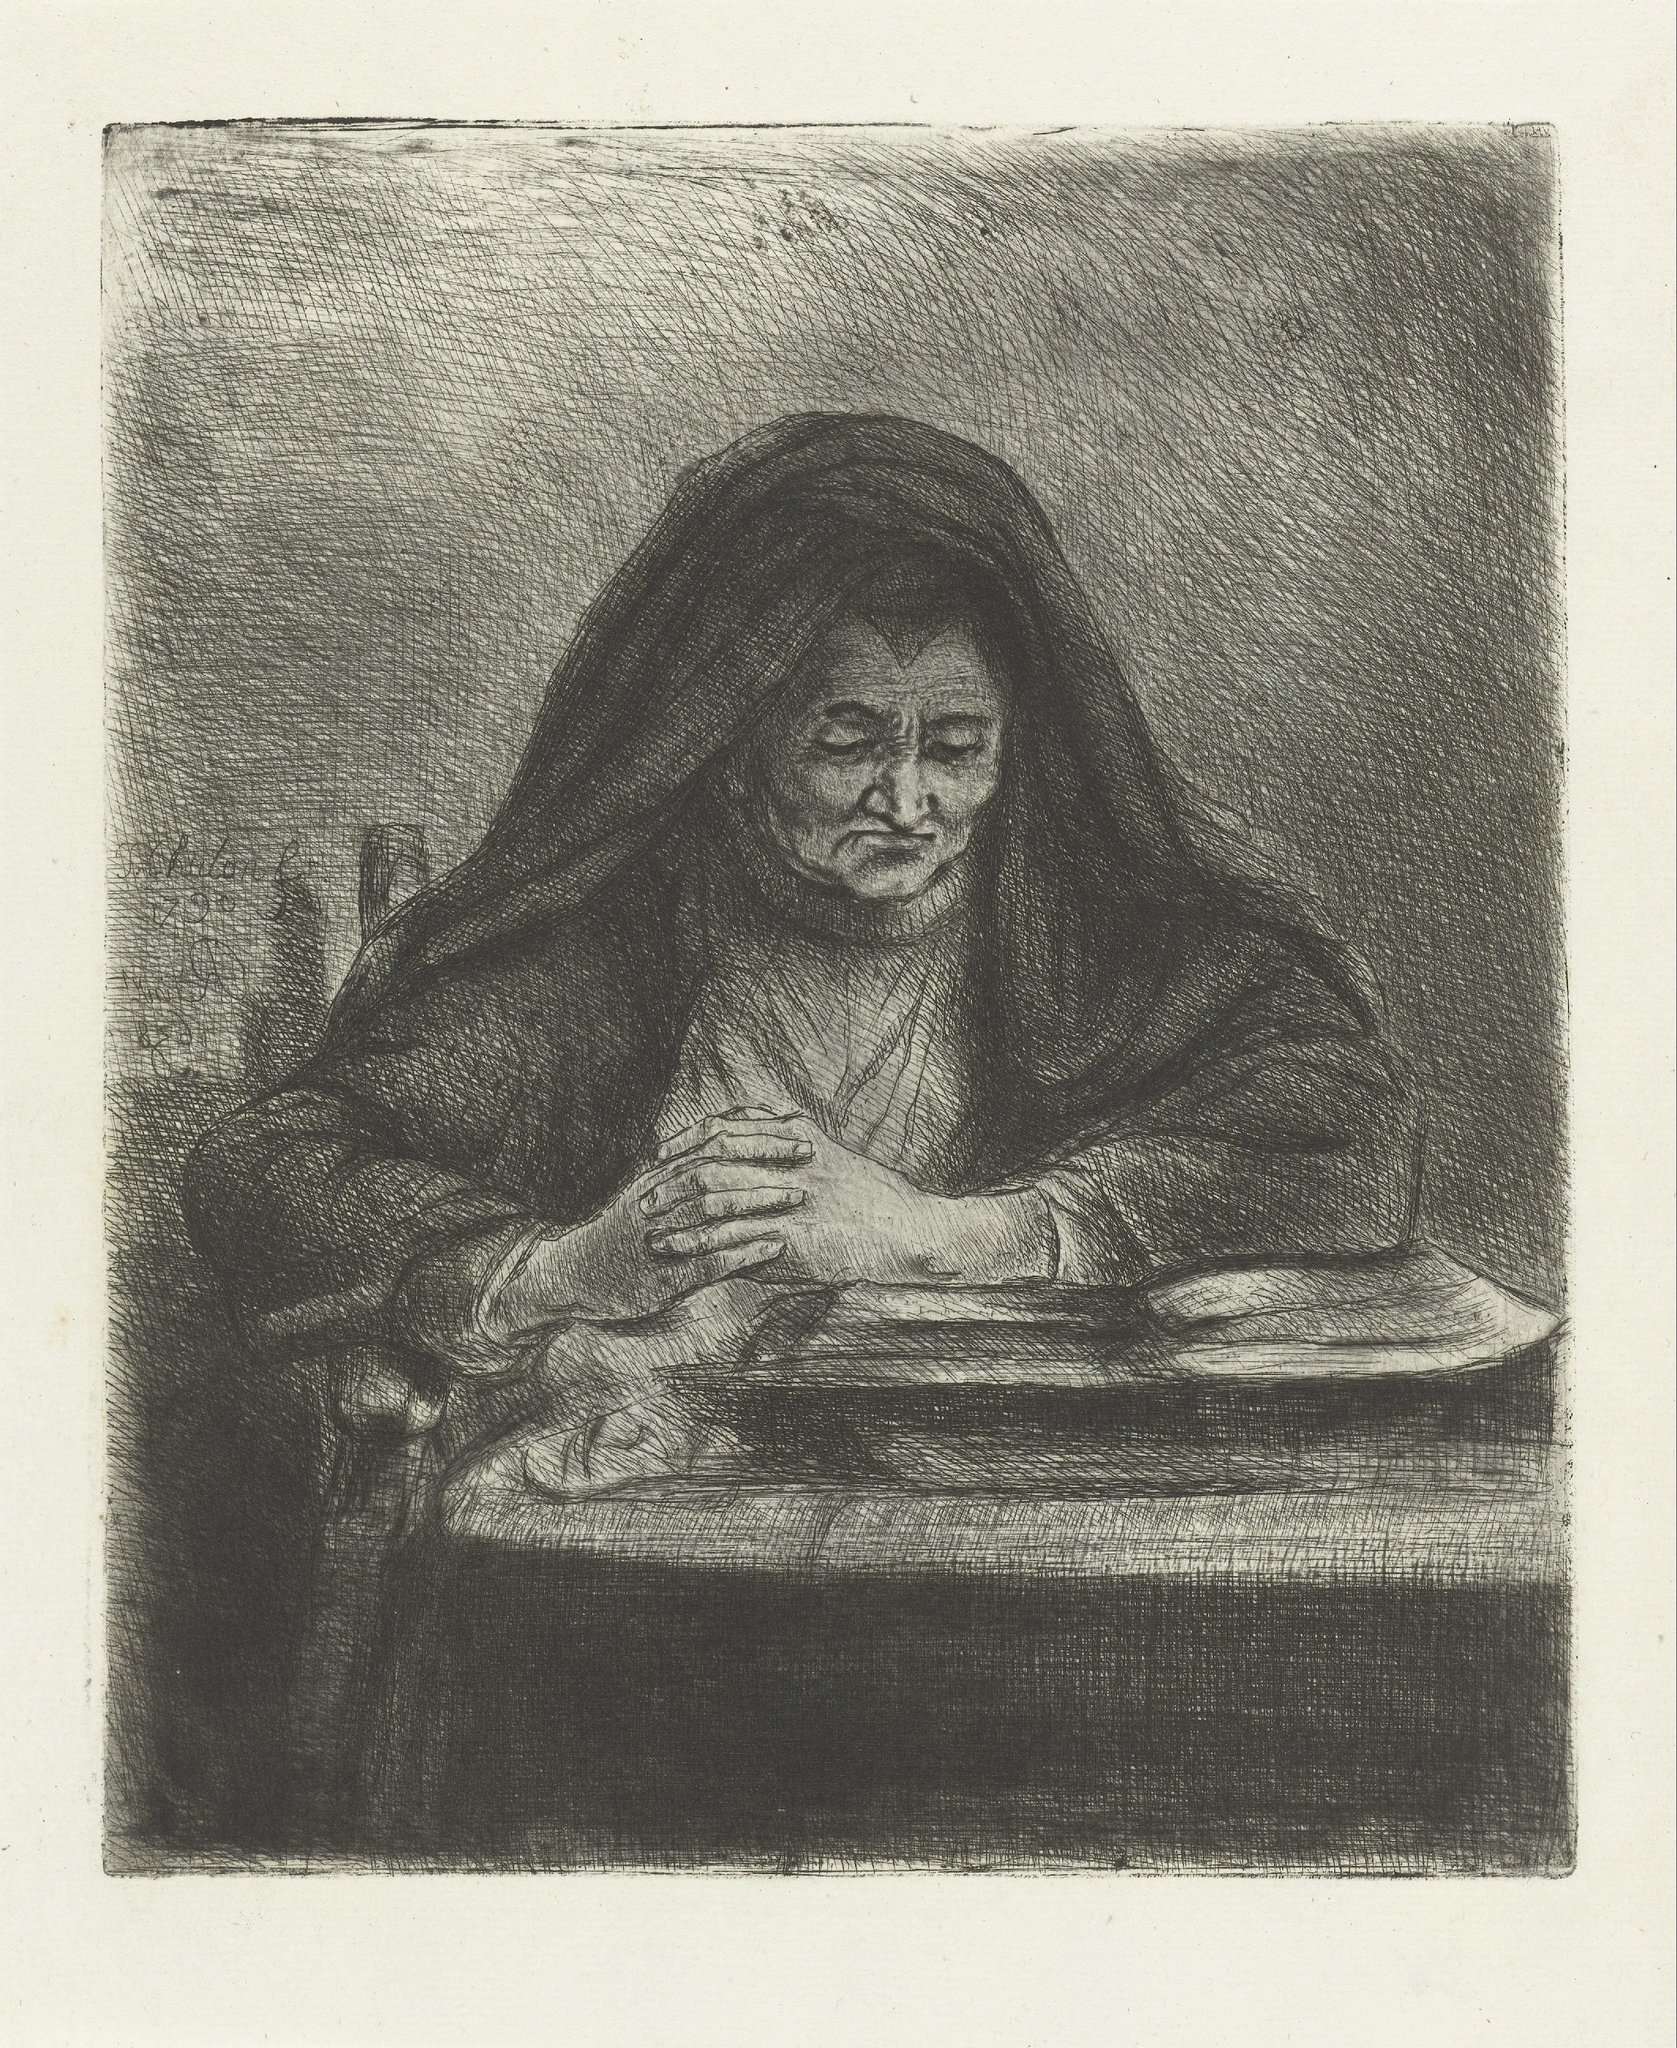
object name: print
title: Lezende vrouw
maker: jan chalon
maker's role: print maker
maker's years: 1738-1795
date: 1790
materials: paper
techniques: drypoint, etching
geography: northern netherlands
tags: reading, veil, morphology of human expression (+ old female (human being))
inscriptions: collector's mark: Lugt 2228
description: Een oude vrouw met zwarte sluier. Ze zit op een stoel aan een tafel en leest uit een boek. Haar handen gevouwen.